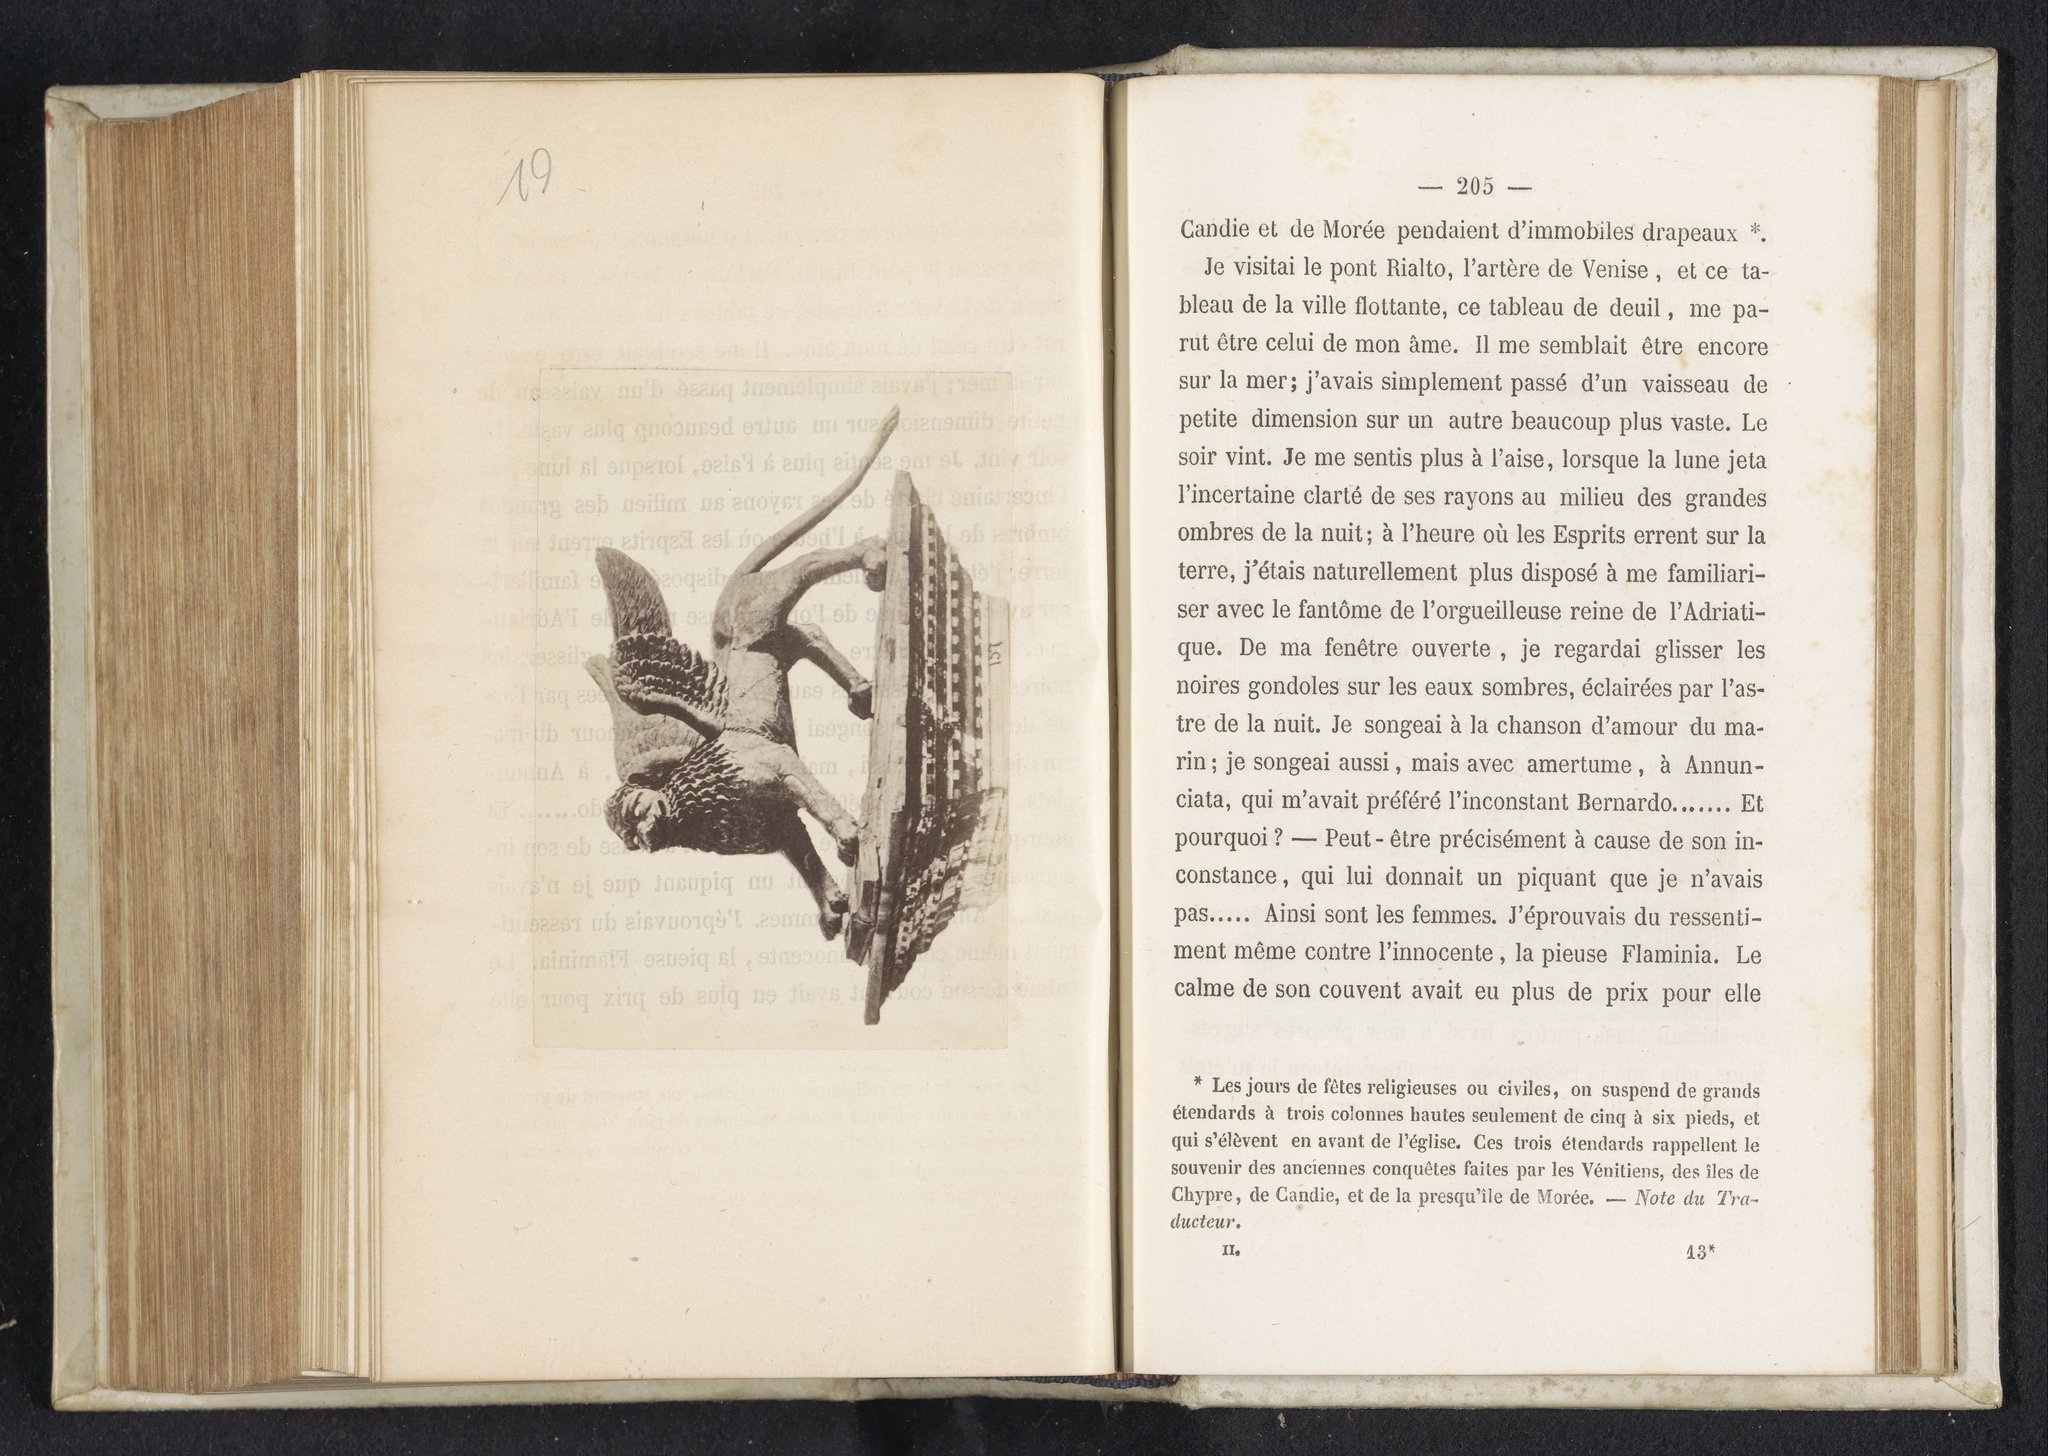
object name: page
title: Sculptuur van de Leeuw van Venetië op de Zuil van San Marco te Venetië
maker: Anonymous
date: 1850-1860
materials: photographic support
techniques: albumen print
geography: san marco square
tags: sculpture, beasts of prey, predatory animals: lion